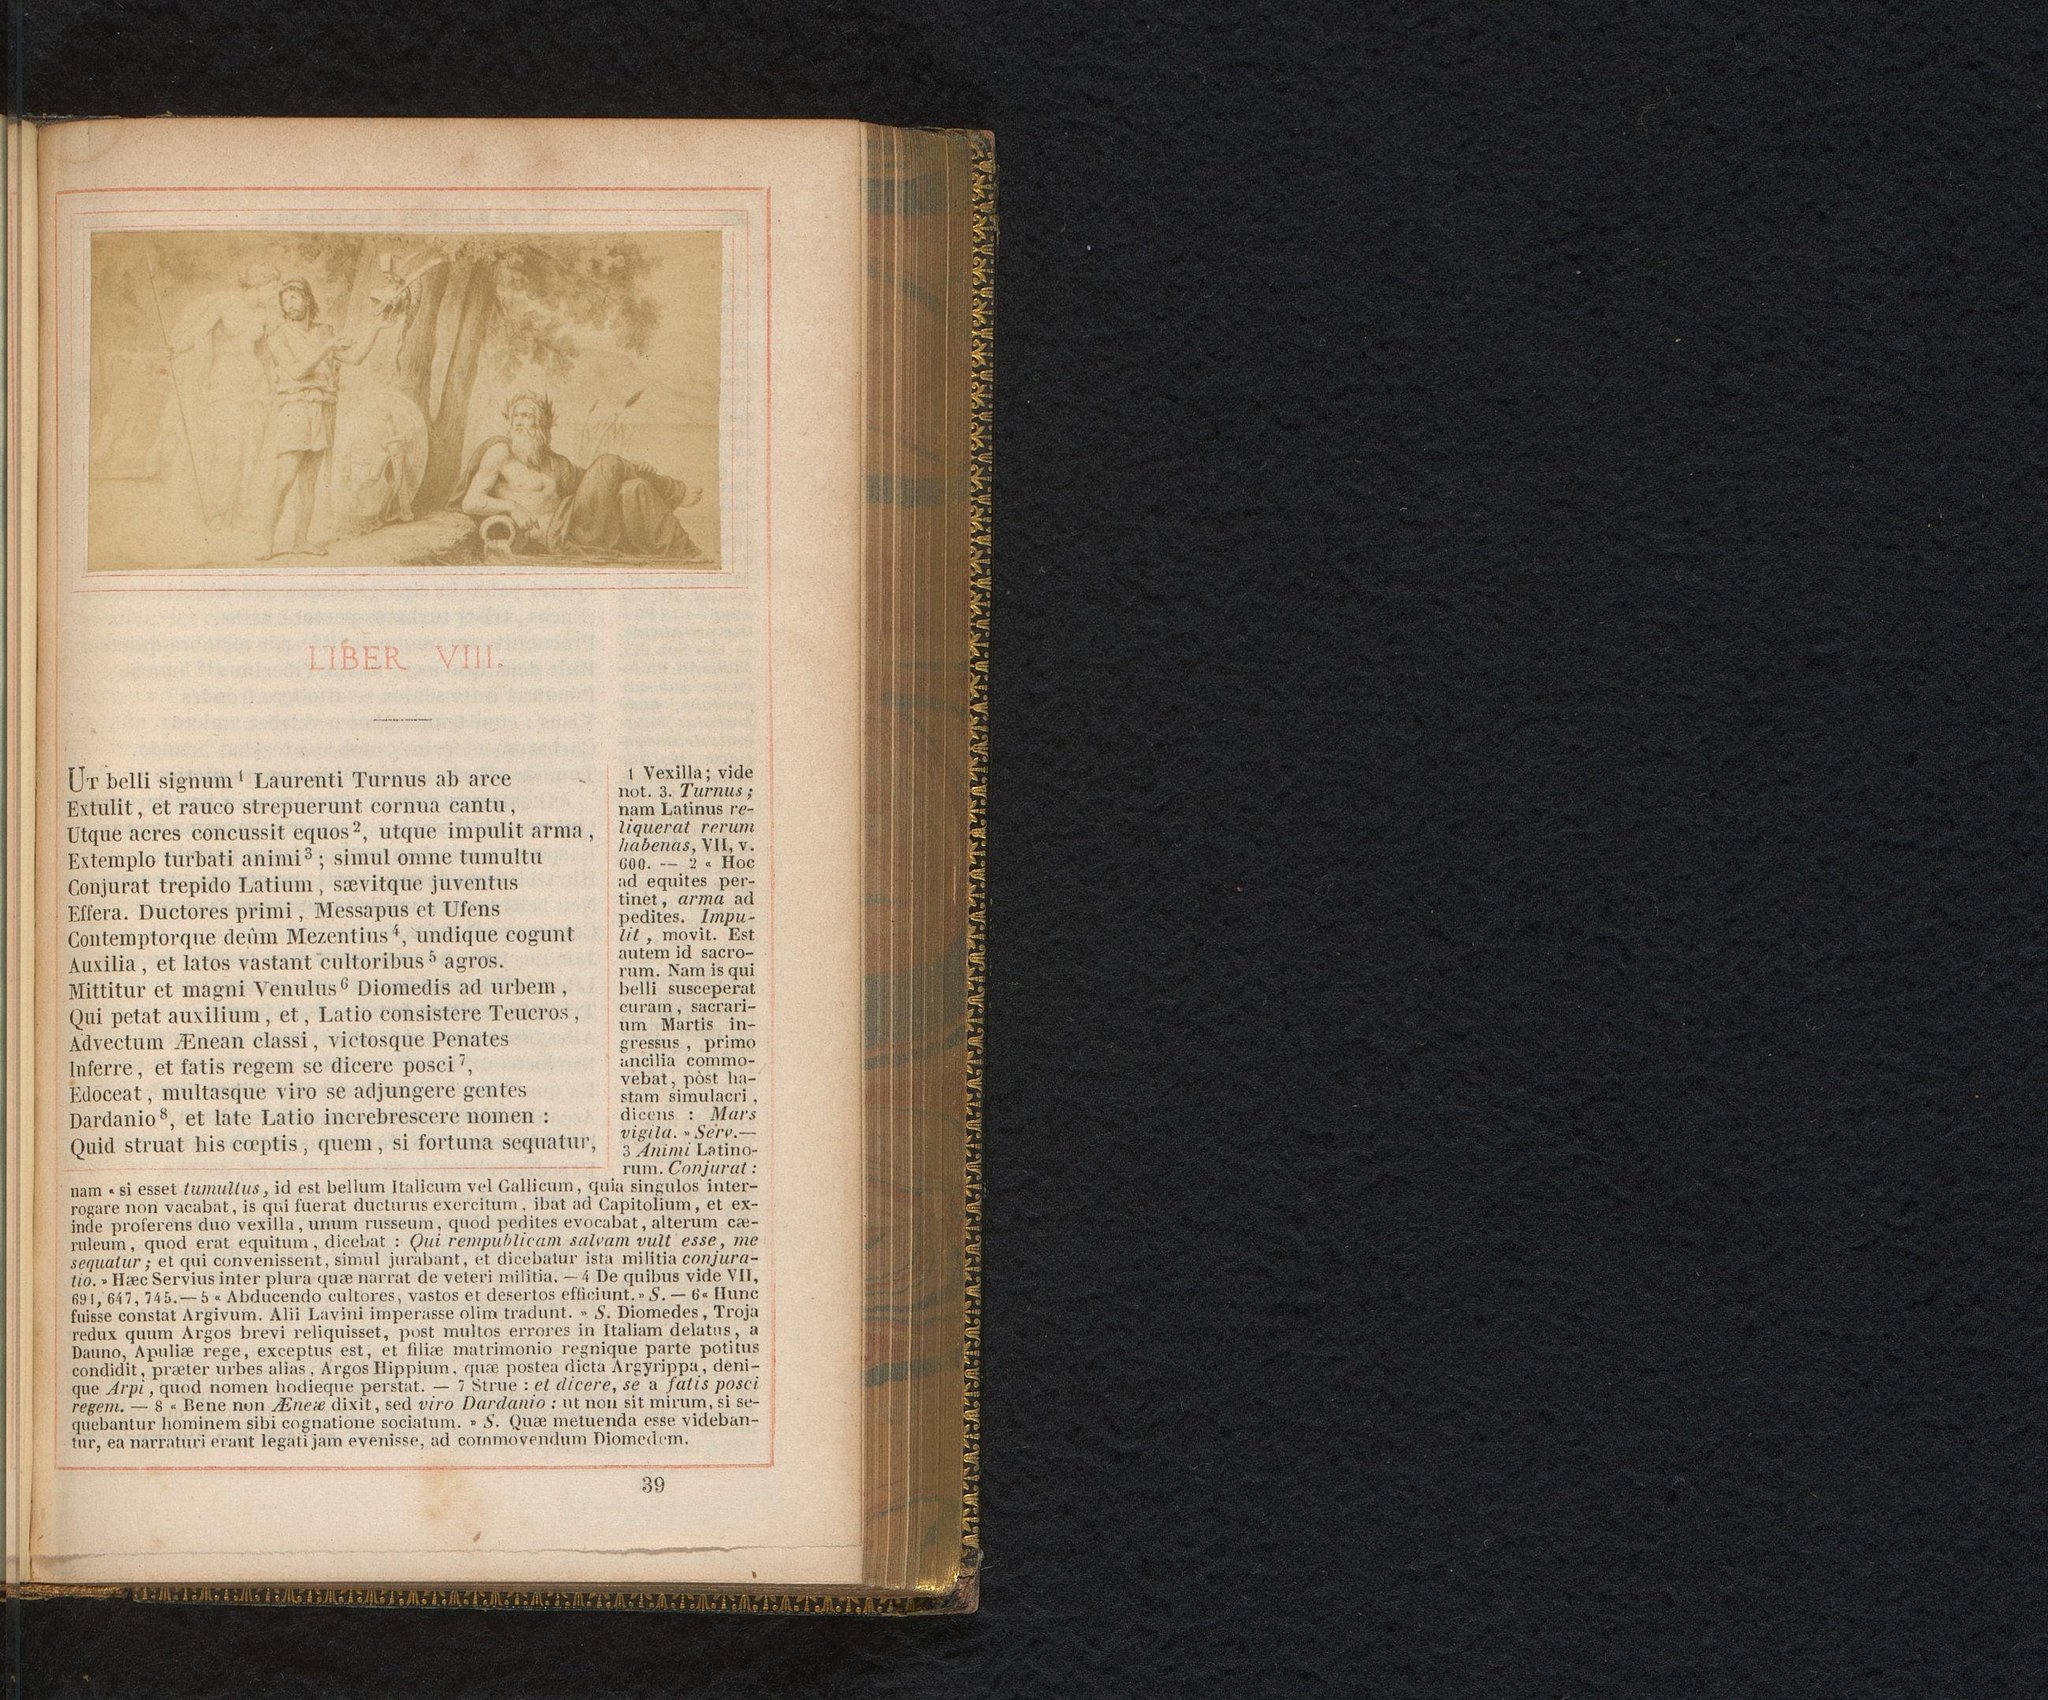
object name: page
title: Fotoreproductie van een schilderij, voorstellende Aeneas ontvangt nieuwe wapens van Venus, scène uit Virgilius' Aeneis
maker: Anonymous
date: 1853-1858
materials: paper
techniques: albumen print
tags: venus hands over the armour to aeneas